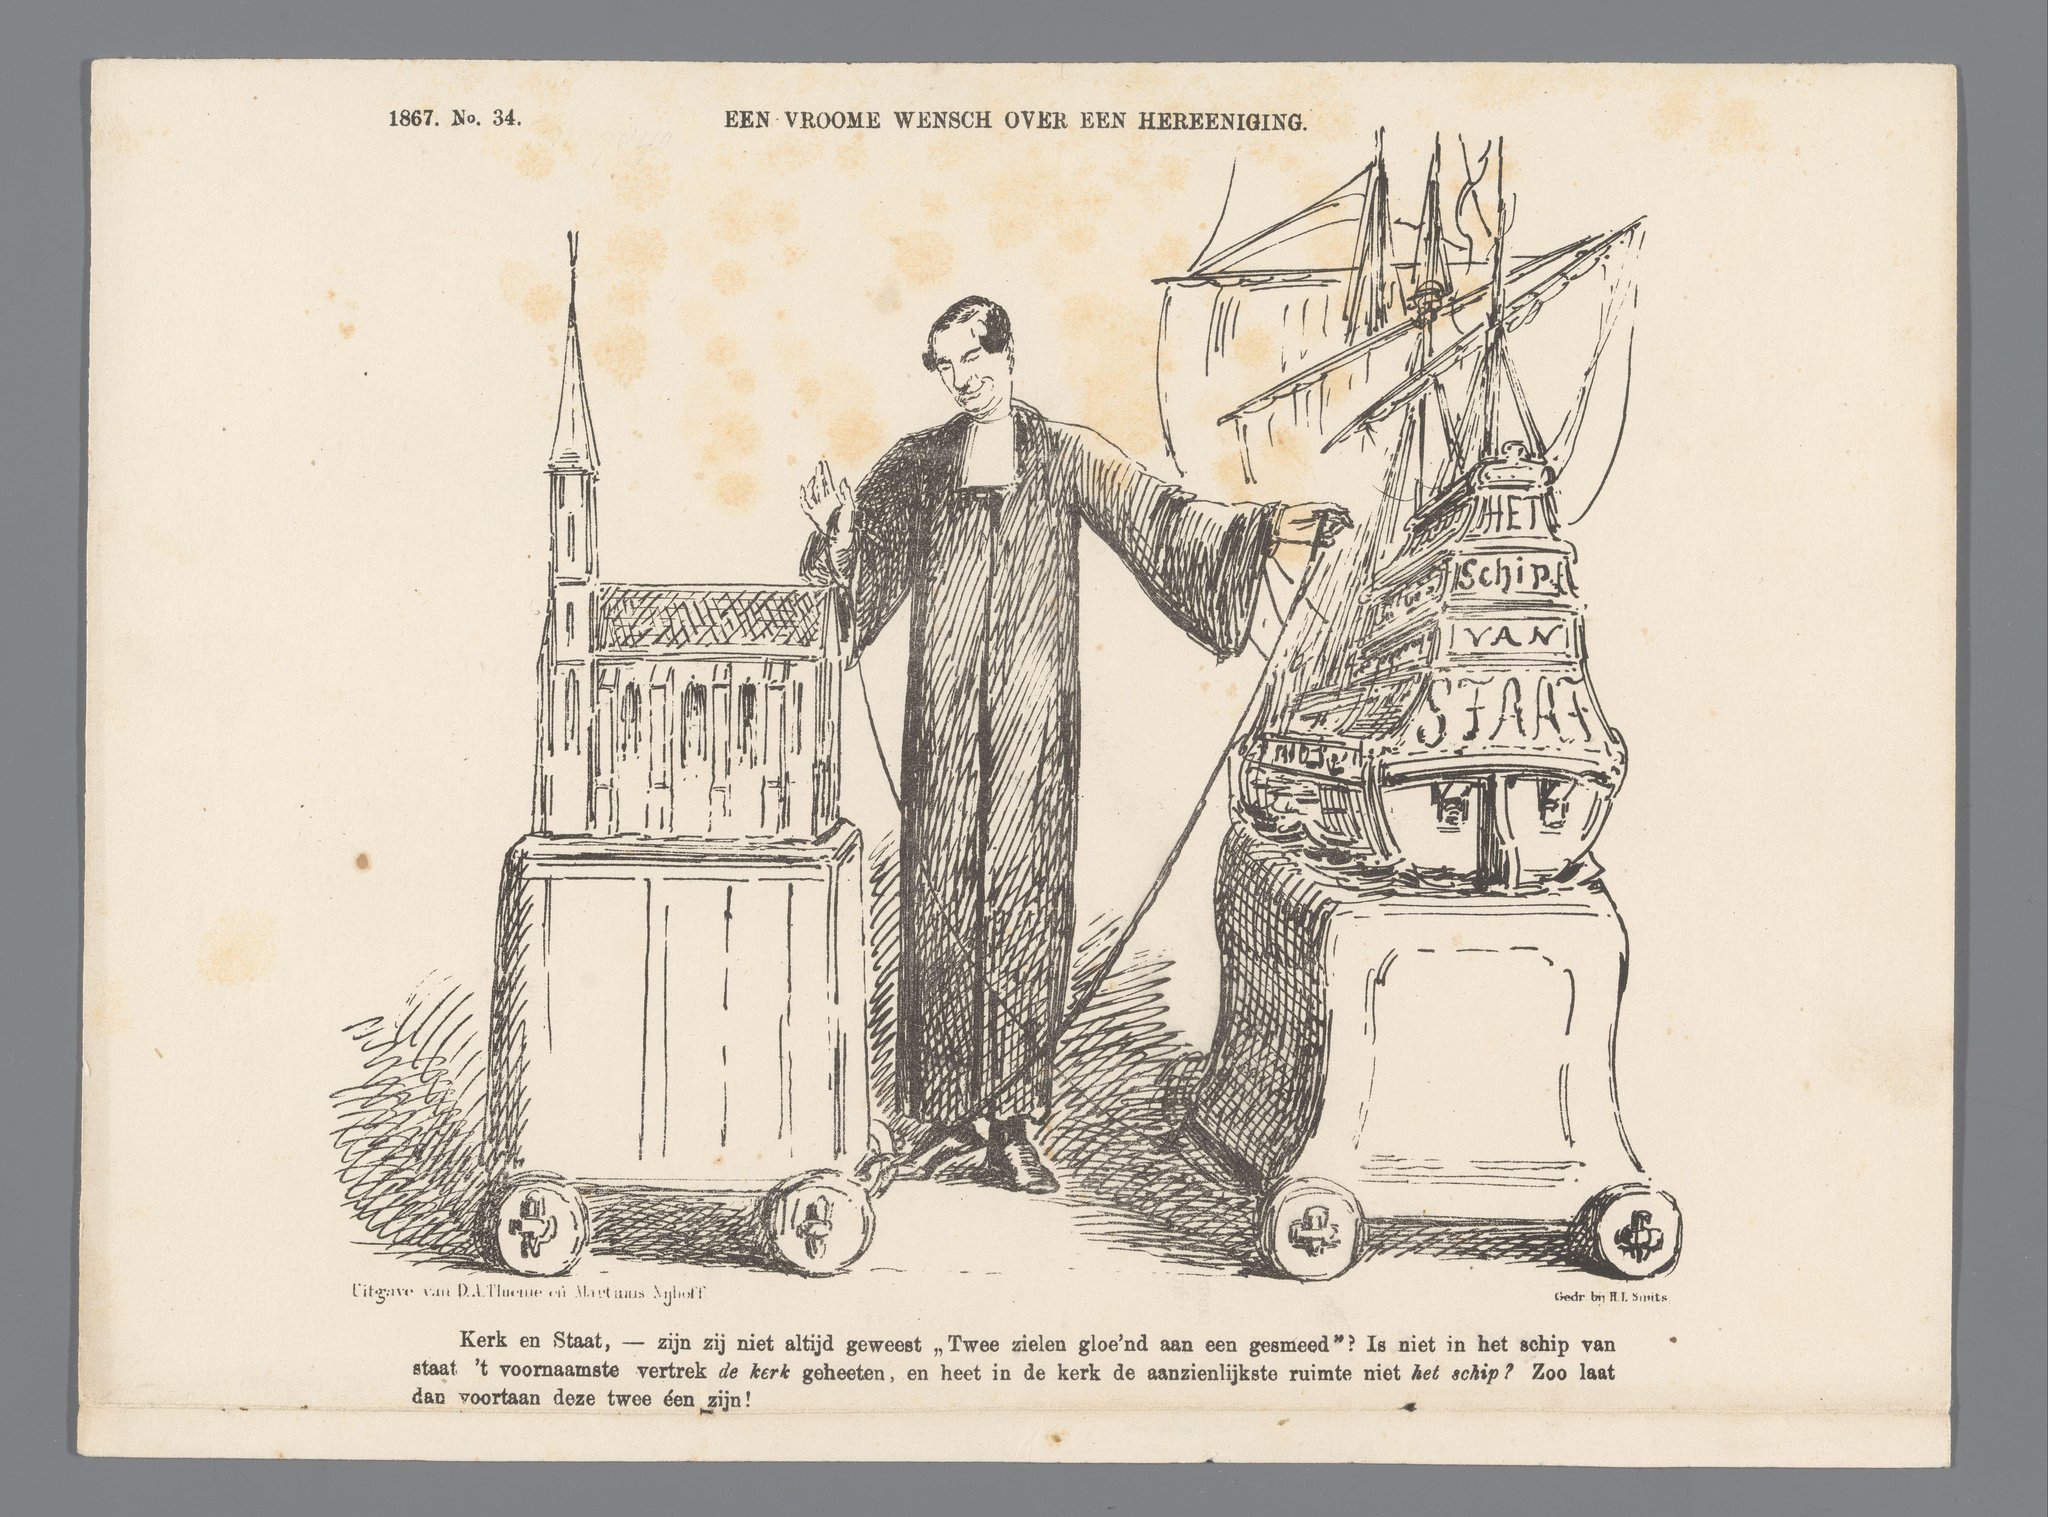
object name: cartoon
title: Spotprent over Minister Schimmelpenninck, 1867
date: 1867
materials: paper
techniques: lithograph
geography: netherlands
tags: amsterdam, rutger jan graaf schimmelpenninck van nyenhuis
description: Spotprent over Minister van Financiën R.J. Schimmelpenninck tegelijkertijd ook belast met het Departement van Hervormde en andere Erediensten. De minister met het Schip van Staat en het model van een kerk op rolwagens. Plaat verschenen bij het weekblad De Nederlandsche Spectator, nr. 34, 24 augustus 1867.